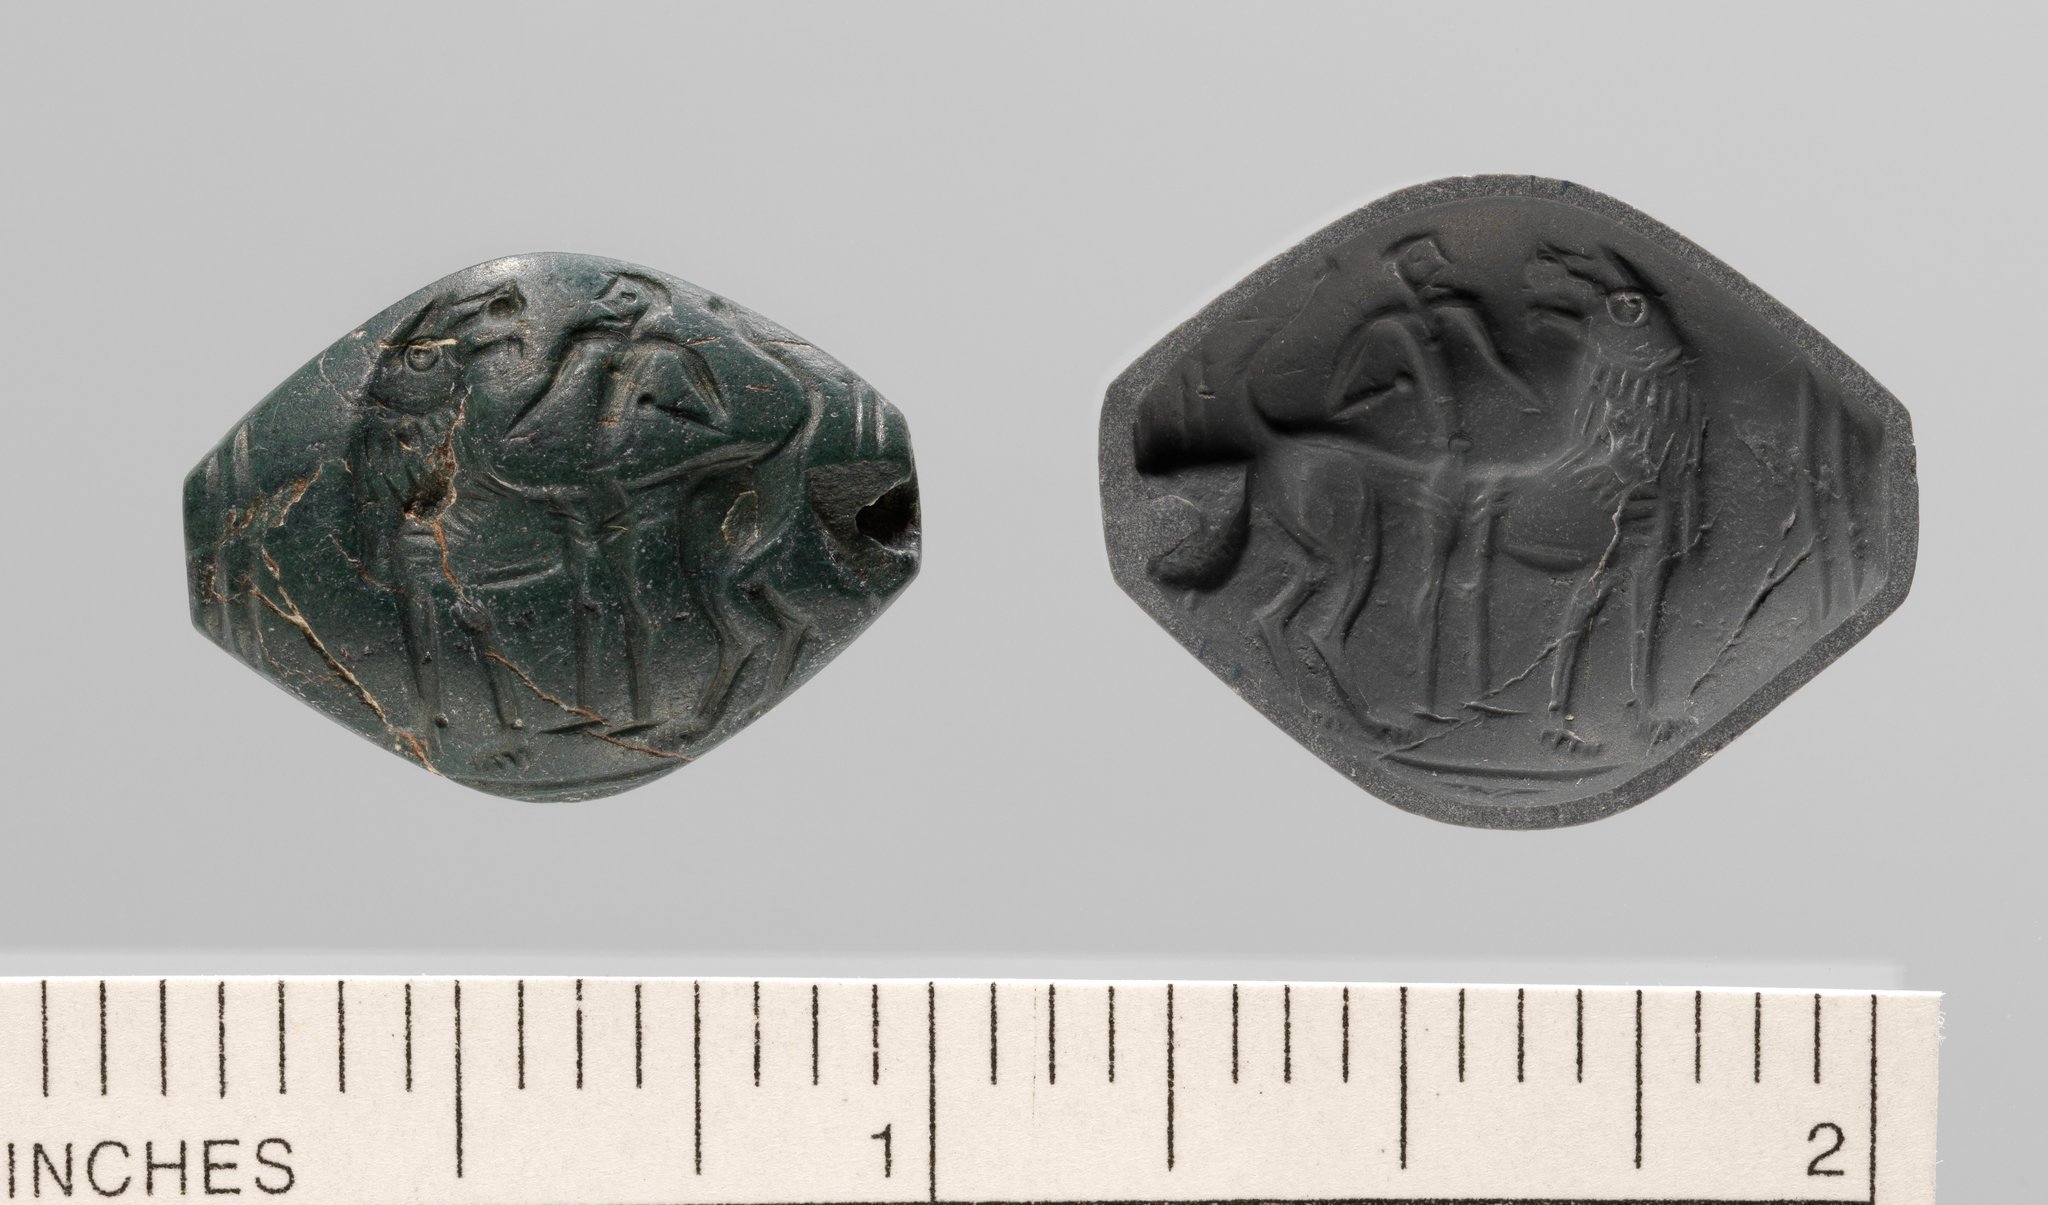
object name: seal, amygdaloid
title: Jasper Amygdaloid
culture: minoan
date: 1450-1375 BCE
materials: jasper